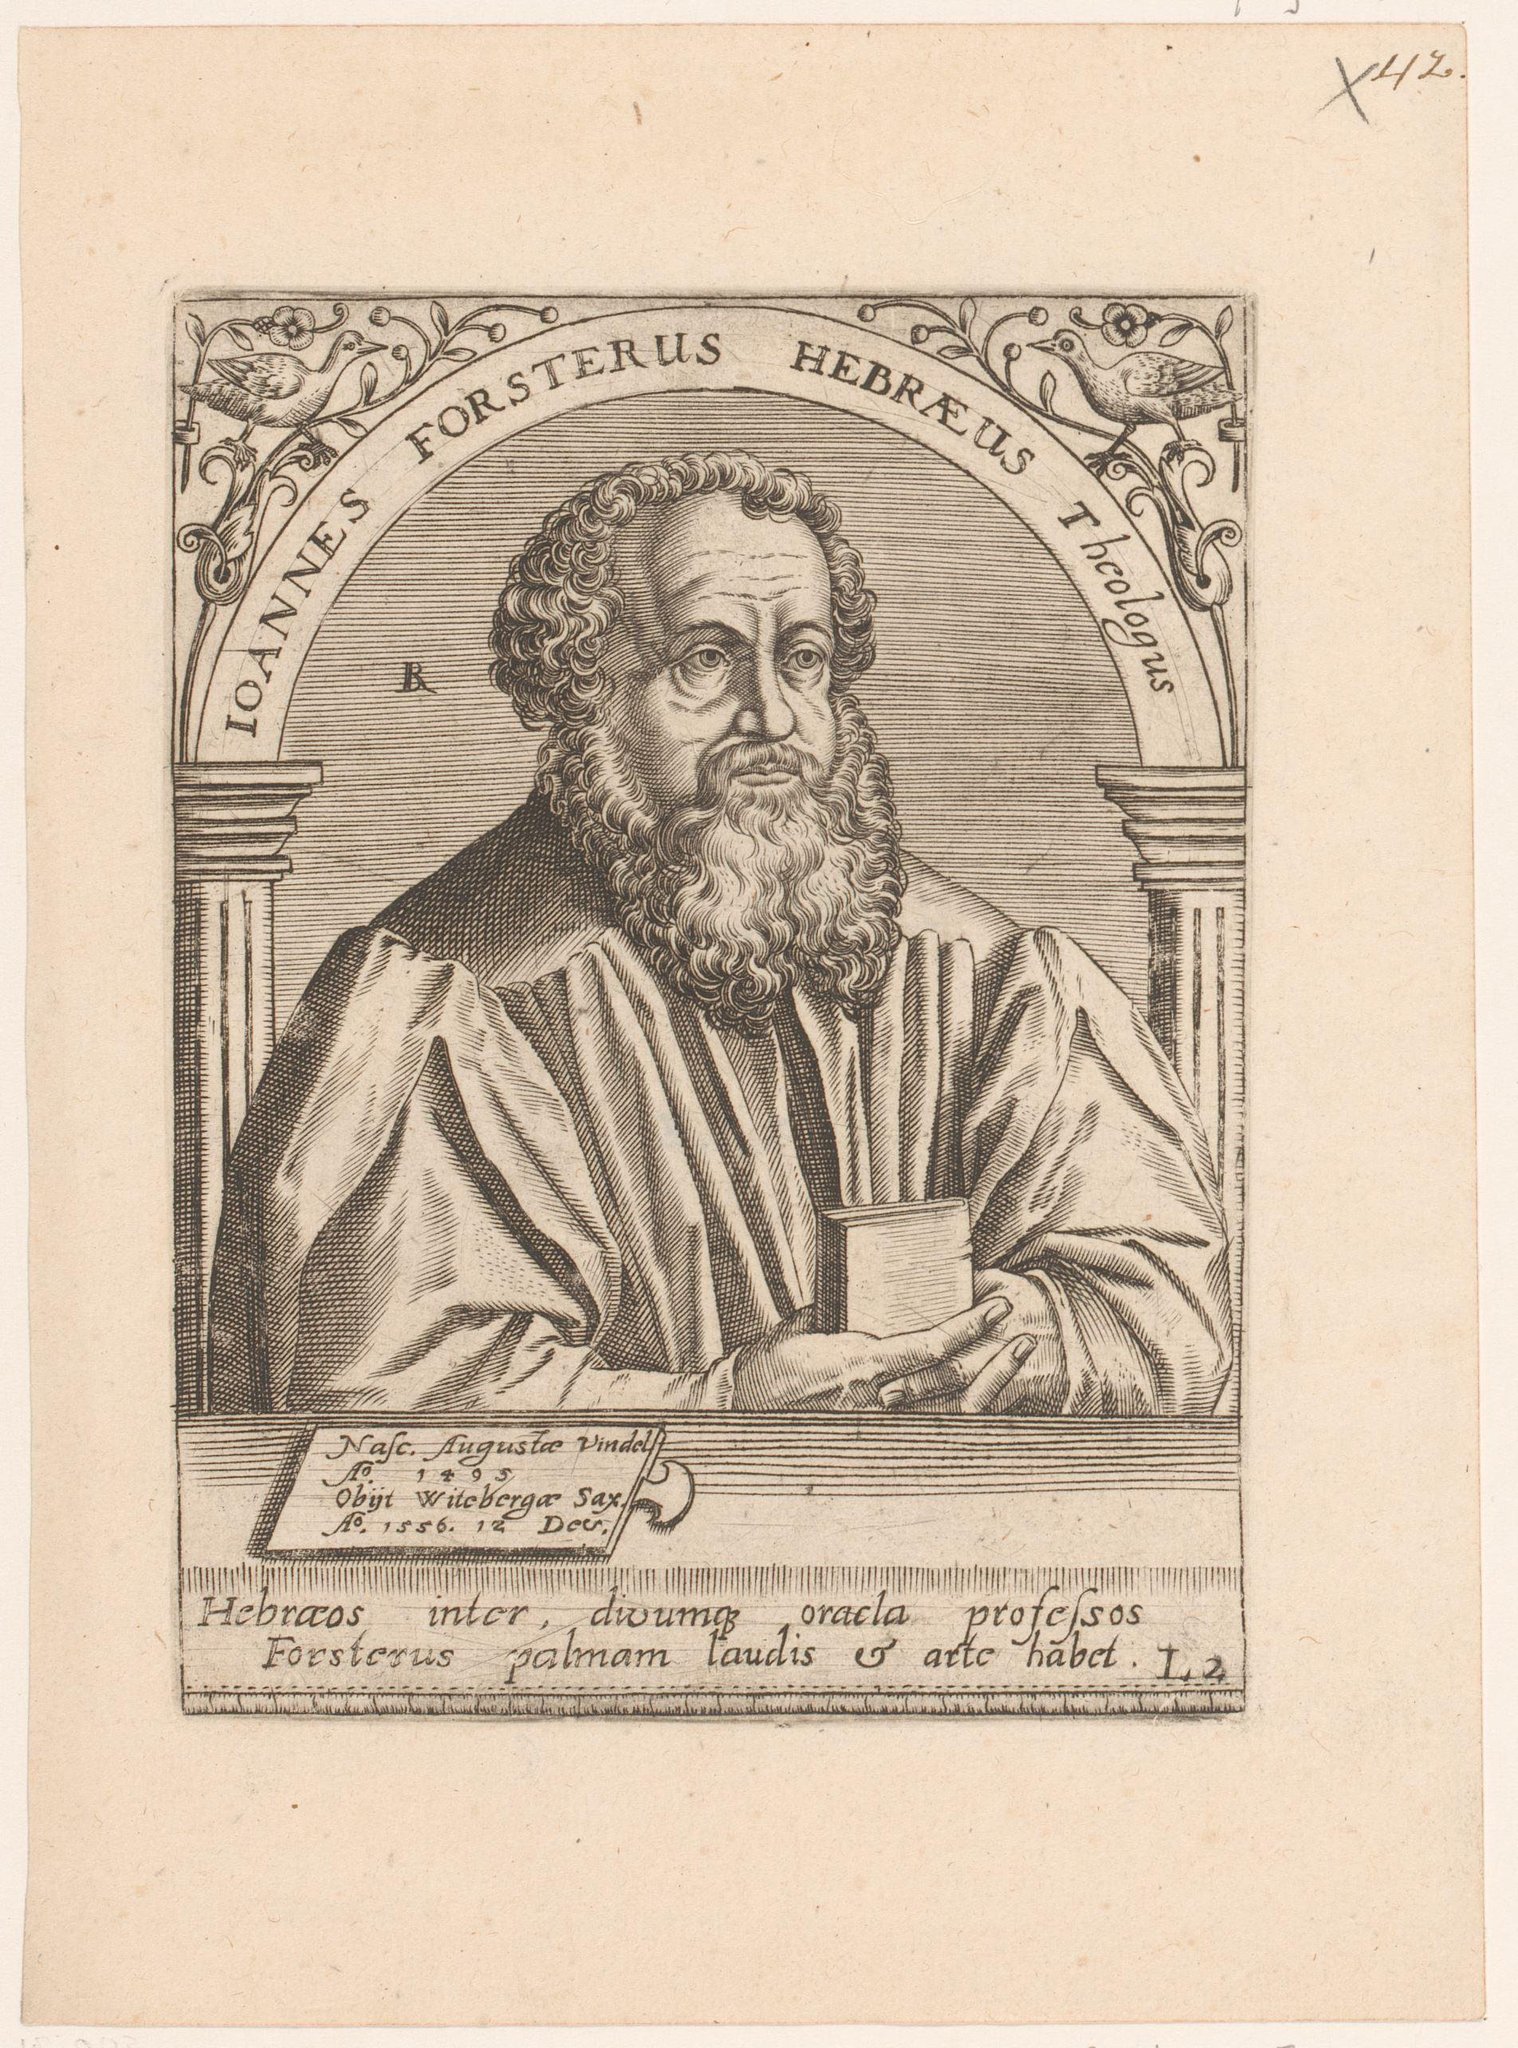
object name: print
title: Joannes Forsterus Hebraeus Theologus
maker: robert boissard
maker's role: print maker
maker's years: 1570-1611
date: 1597-1599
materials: paper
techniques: engraving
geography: france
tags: augsburg, historical persons, book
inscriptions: collector's mark: Lugt 2233